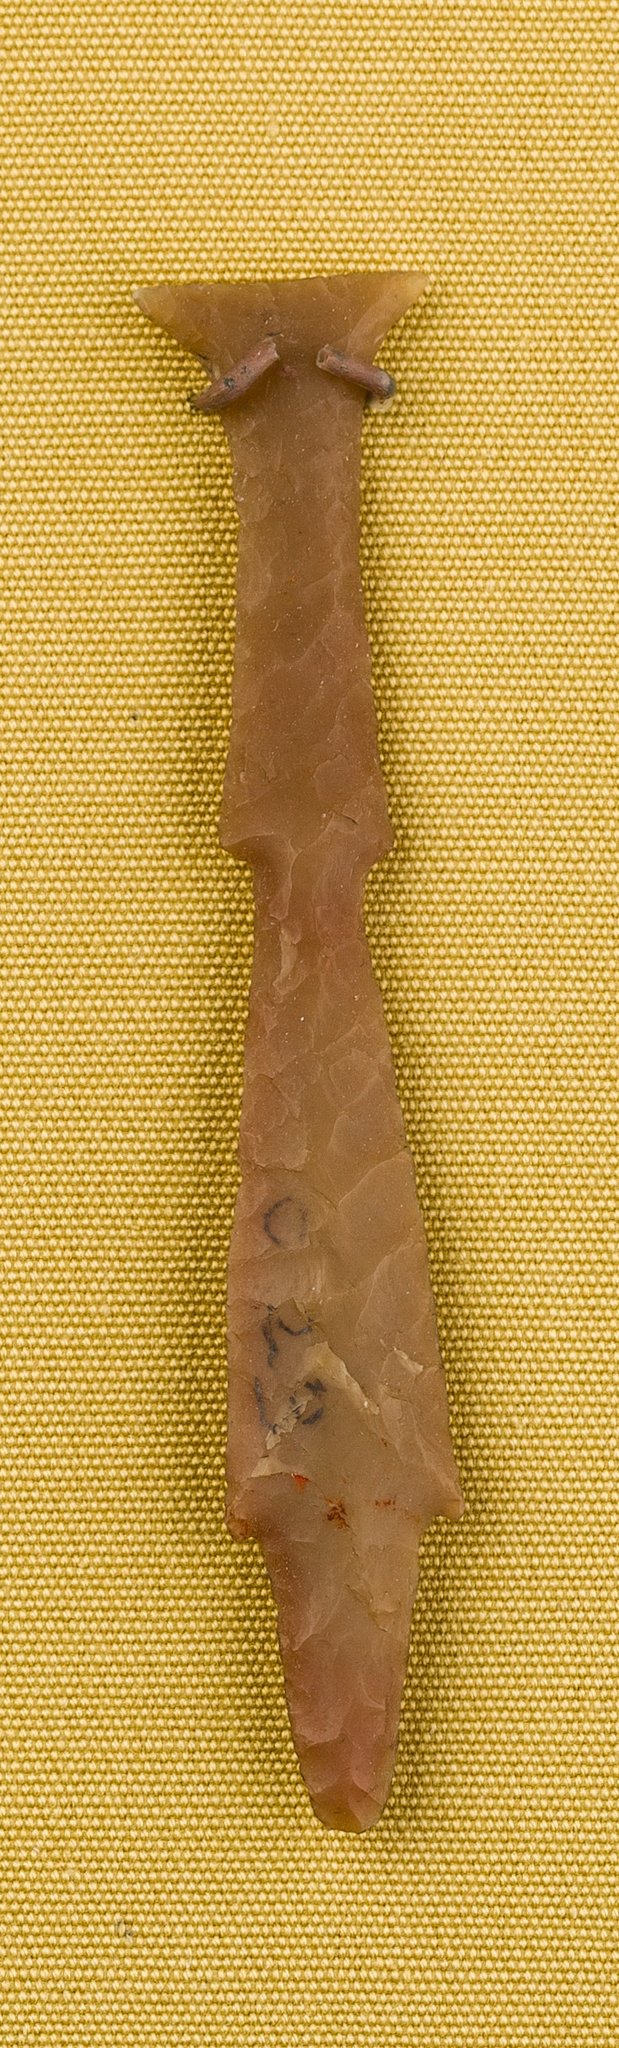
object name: arrowhead, projectile point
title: Notched projectile point with transverse tip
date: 3100-2900 BCE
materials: stone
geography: egypt